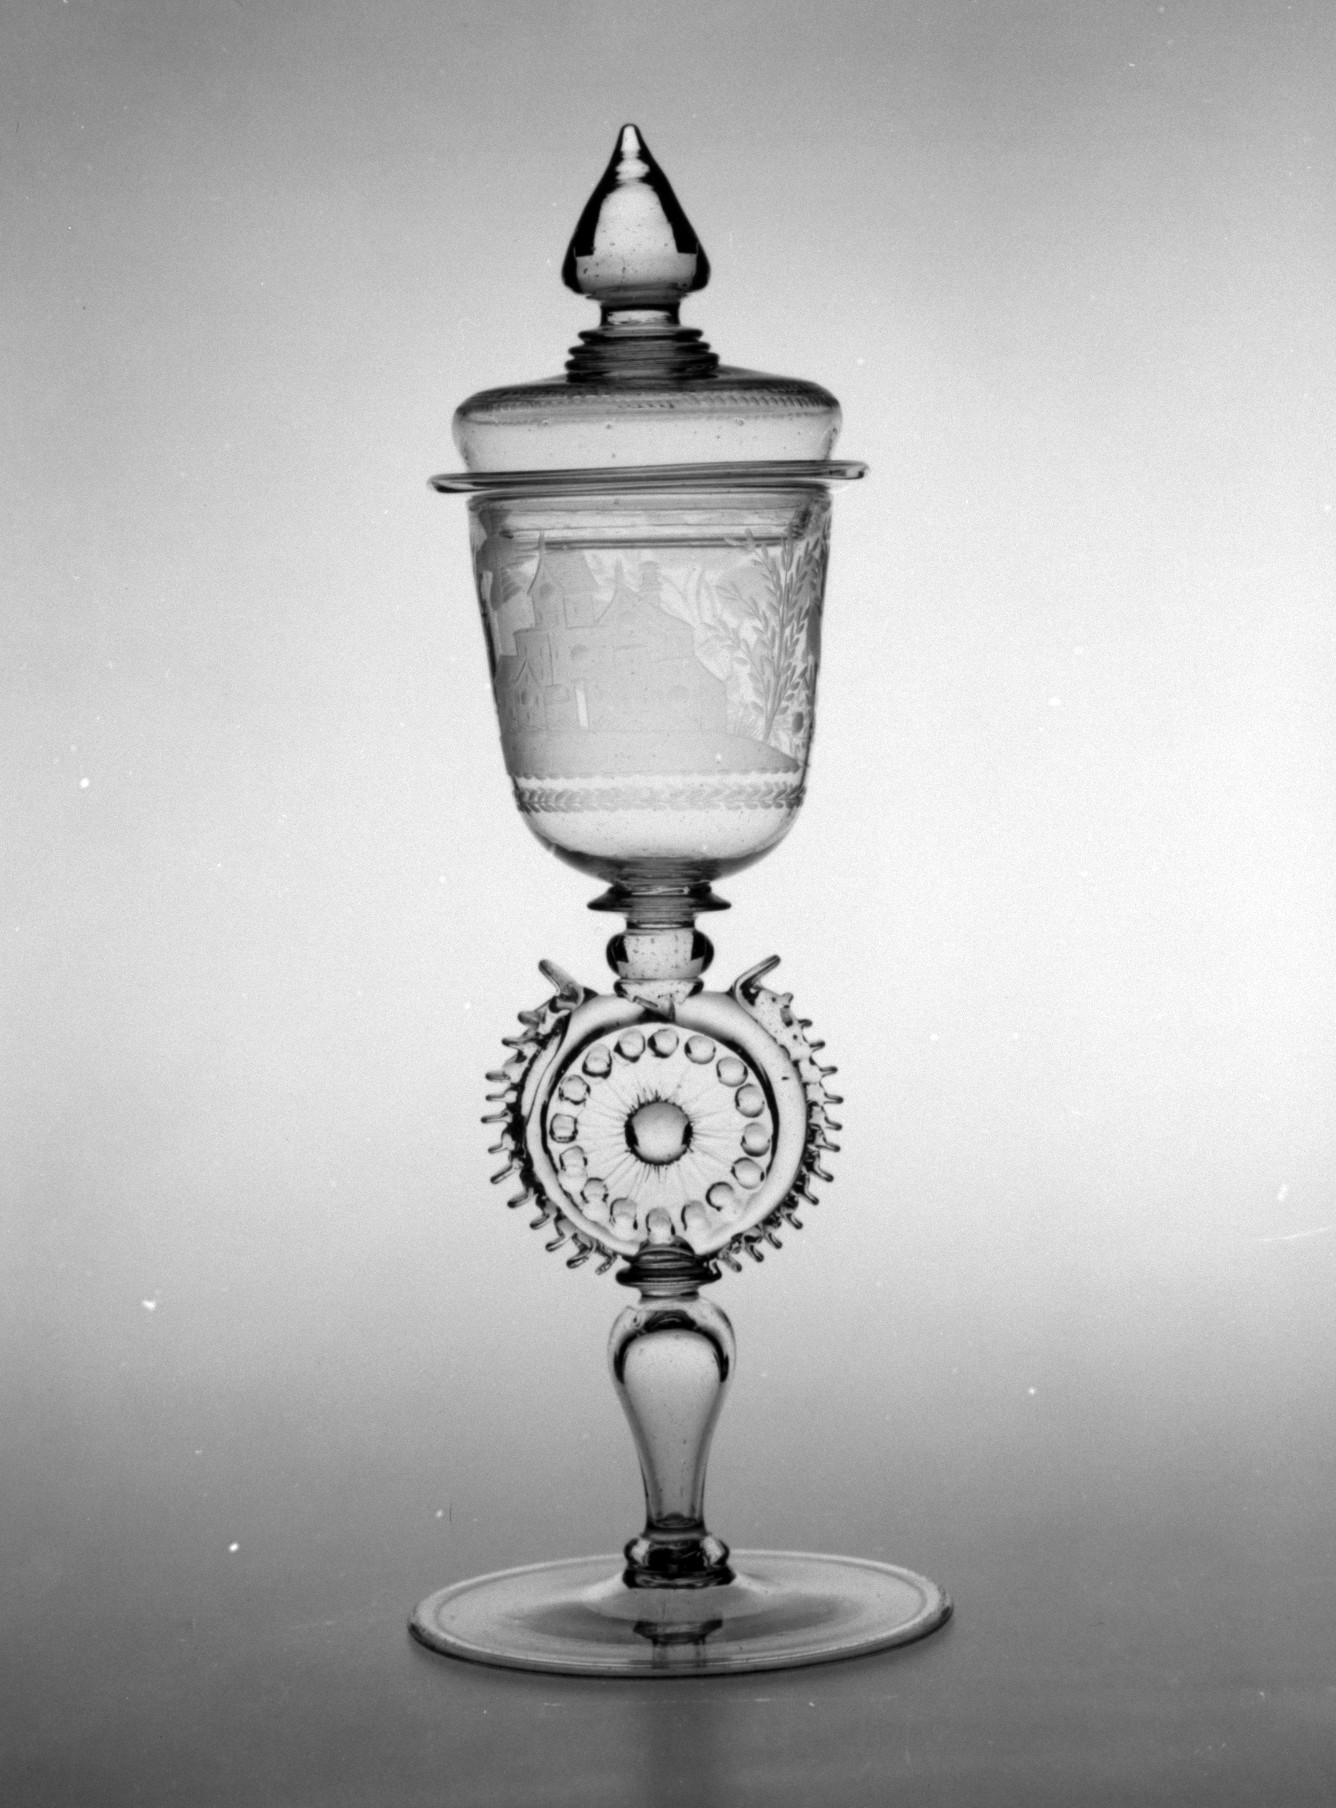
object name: standing cup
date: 1601-1733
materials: glass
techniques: engraving, molding, tooling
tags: buildings,trees